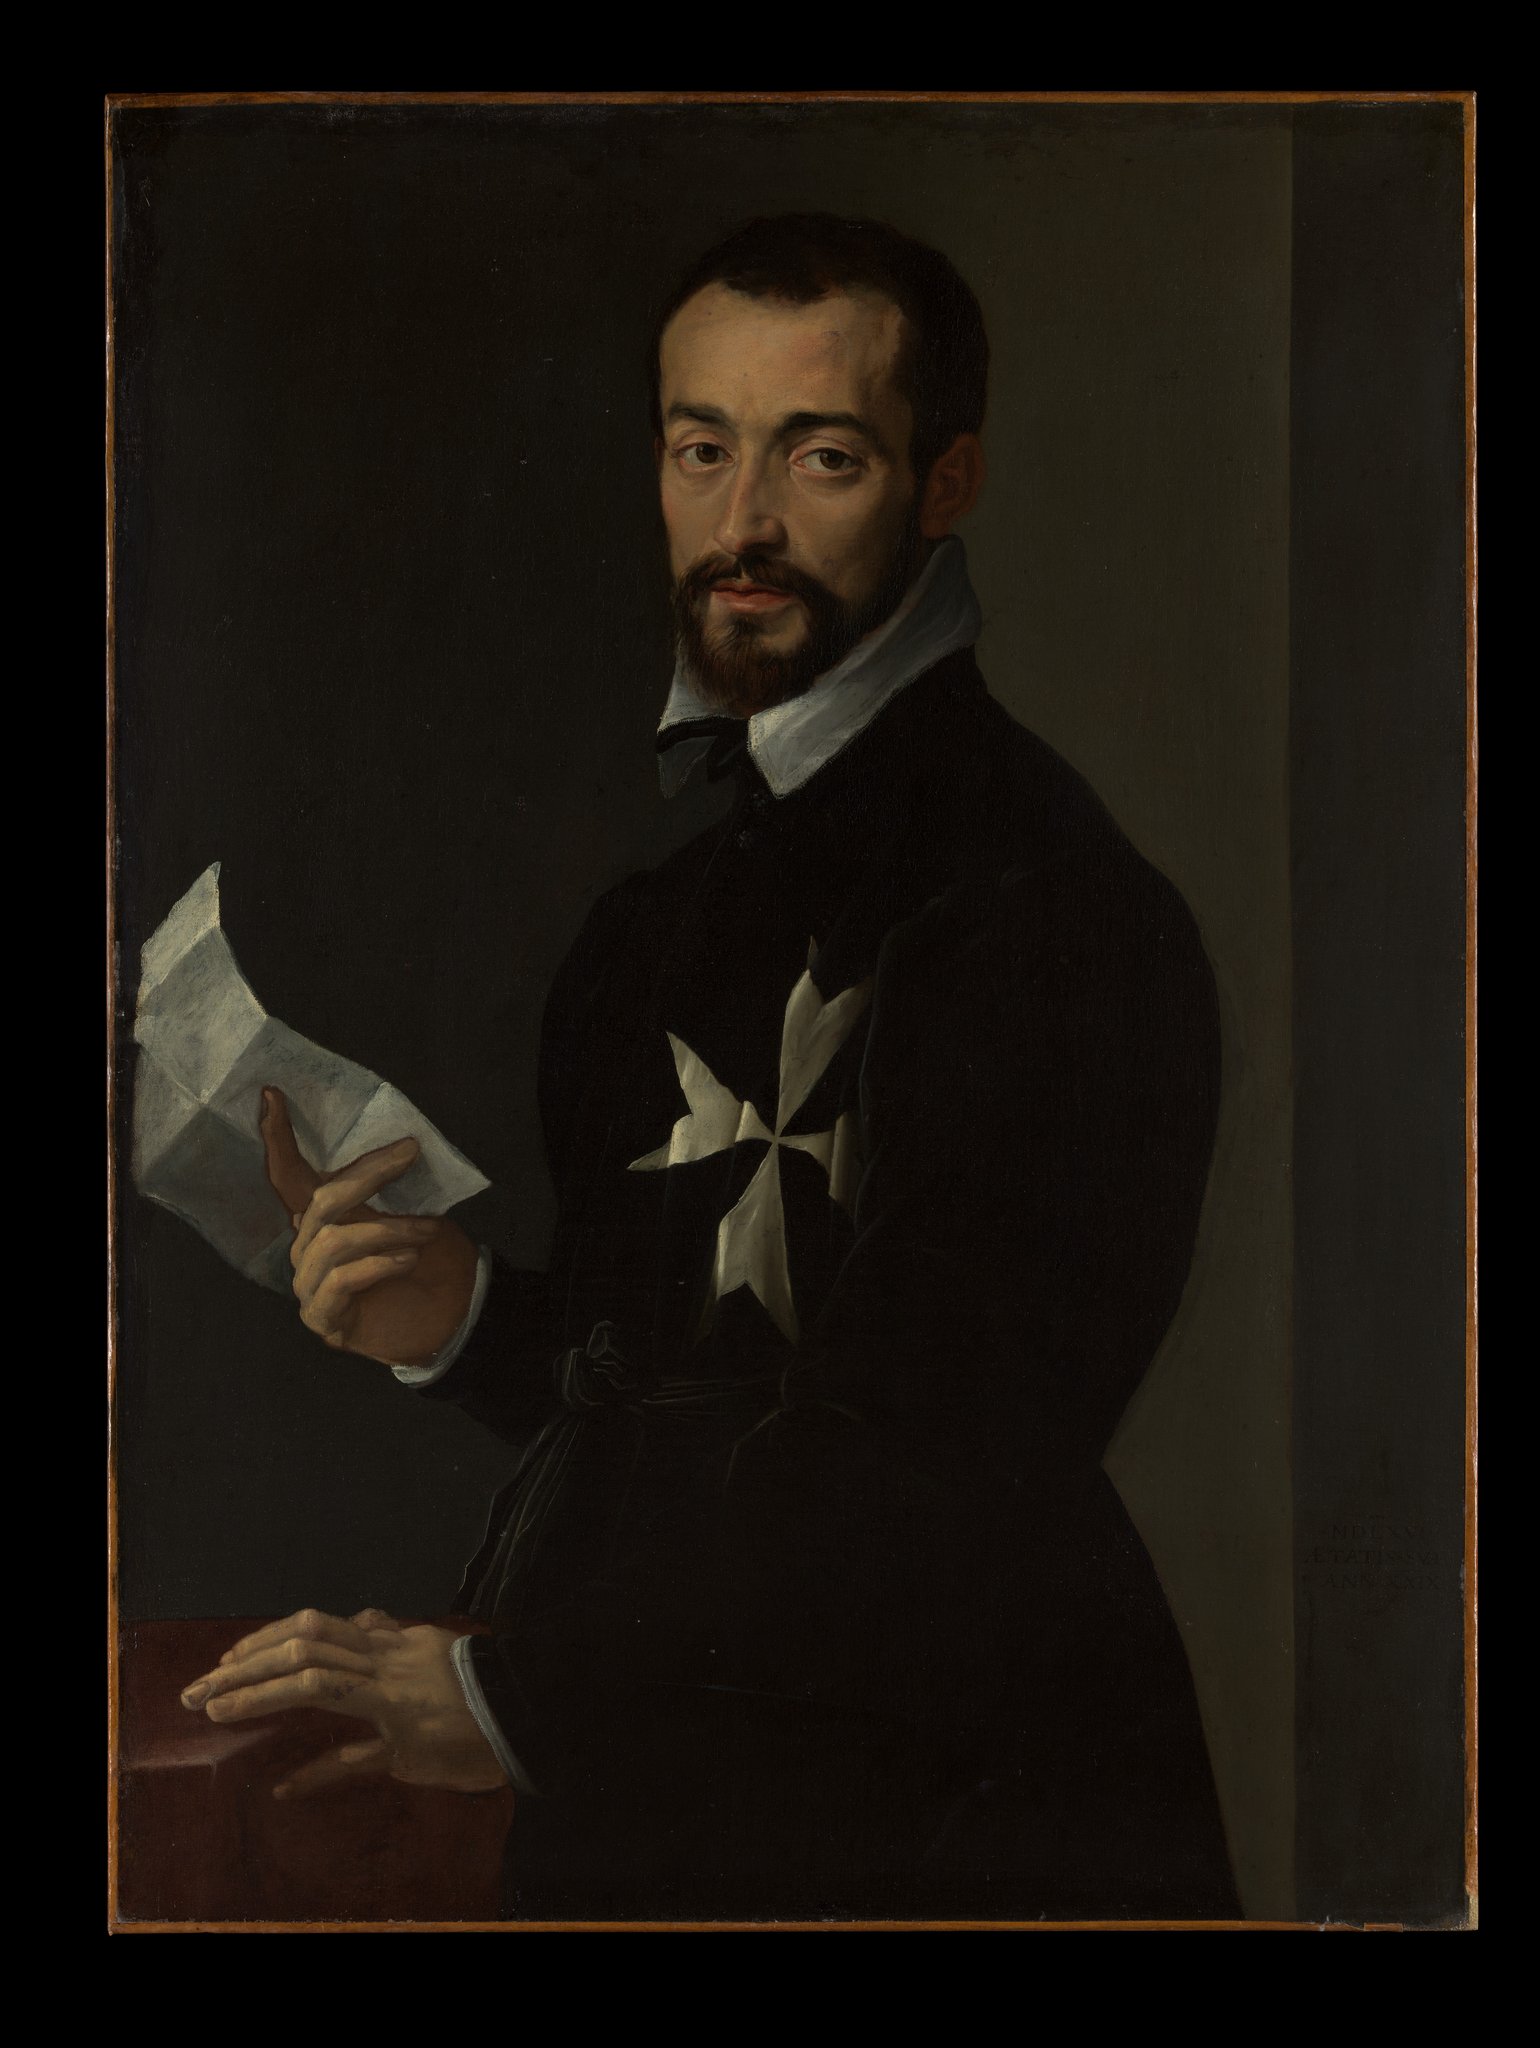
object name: painting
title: Portrait of a Knight of Malta, Probably Fra Jacopo Salviati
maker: mirabello cavalori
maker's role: artist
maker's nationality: italian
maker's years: 1535-1572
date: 1566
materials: canvas, oil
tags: men,portraits,knights